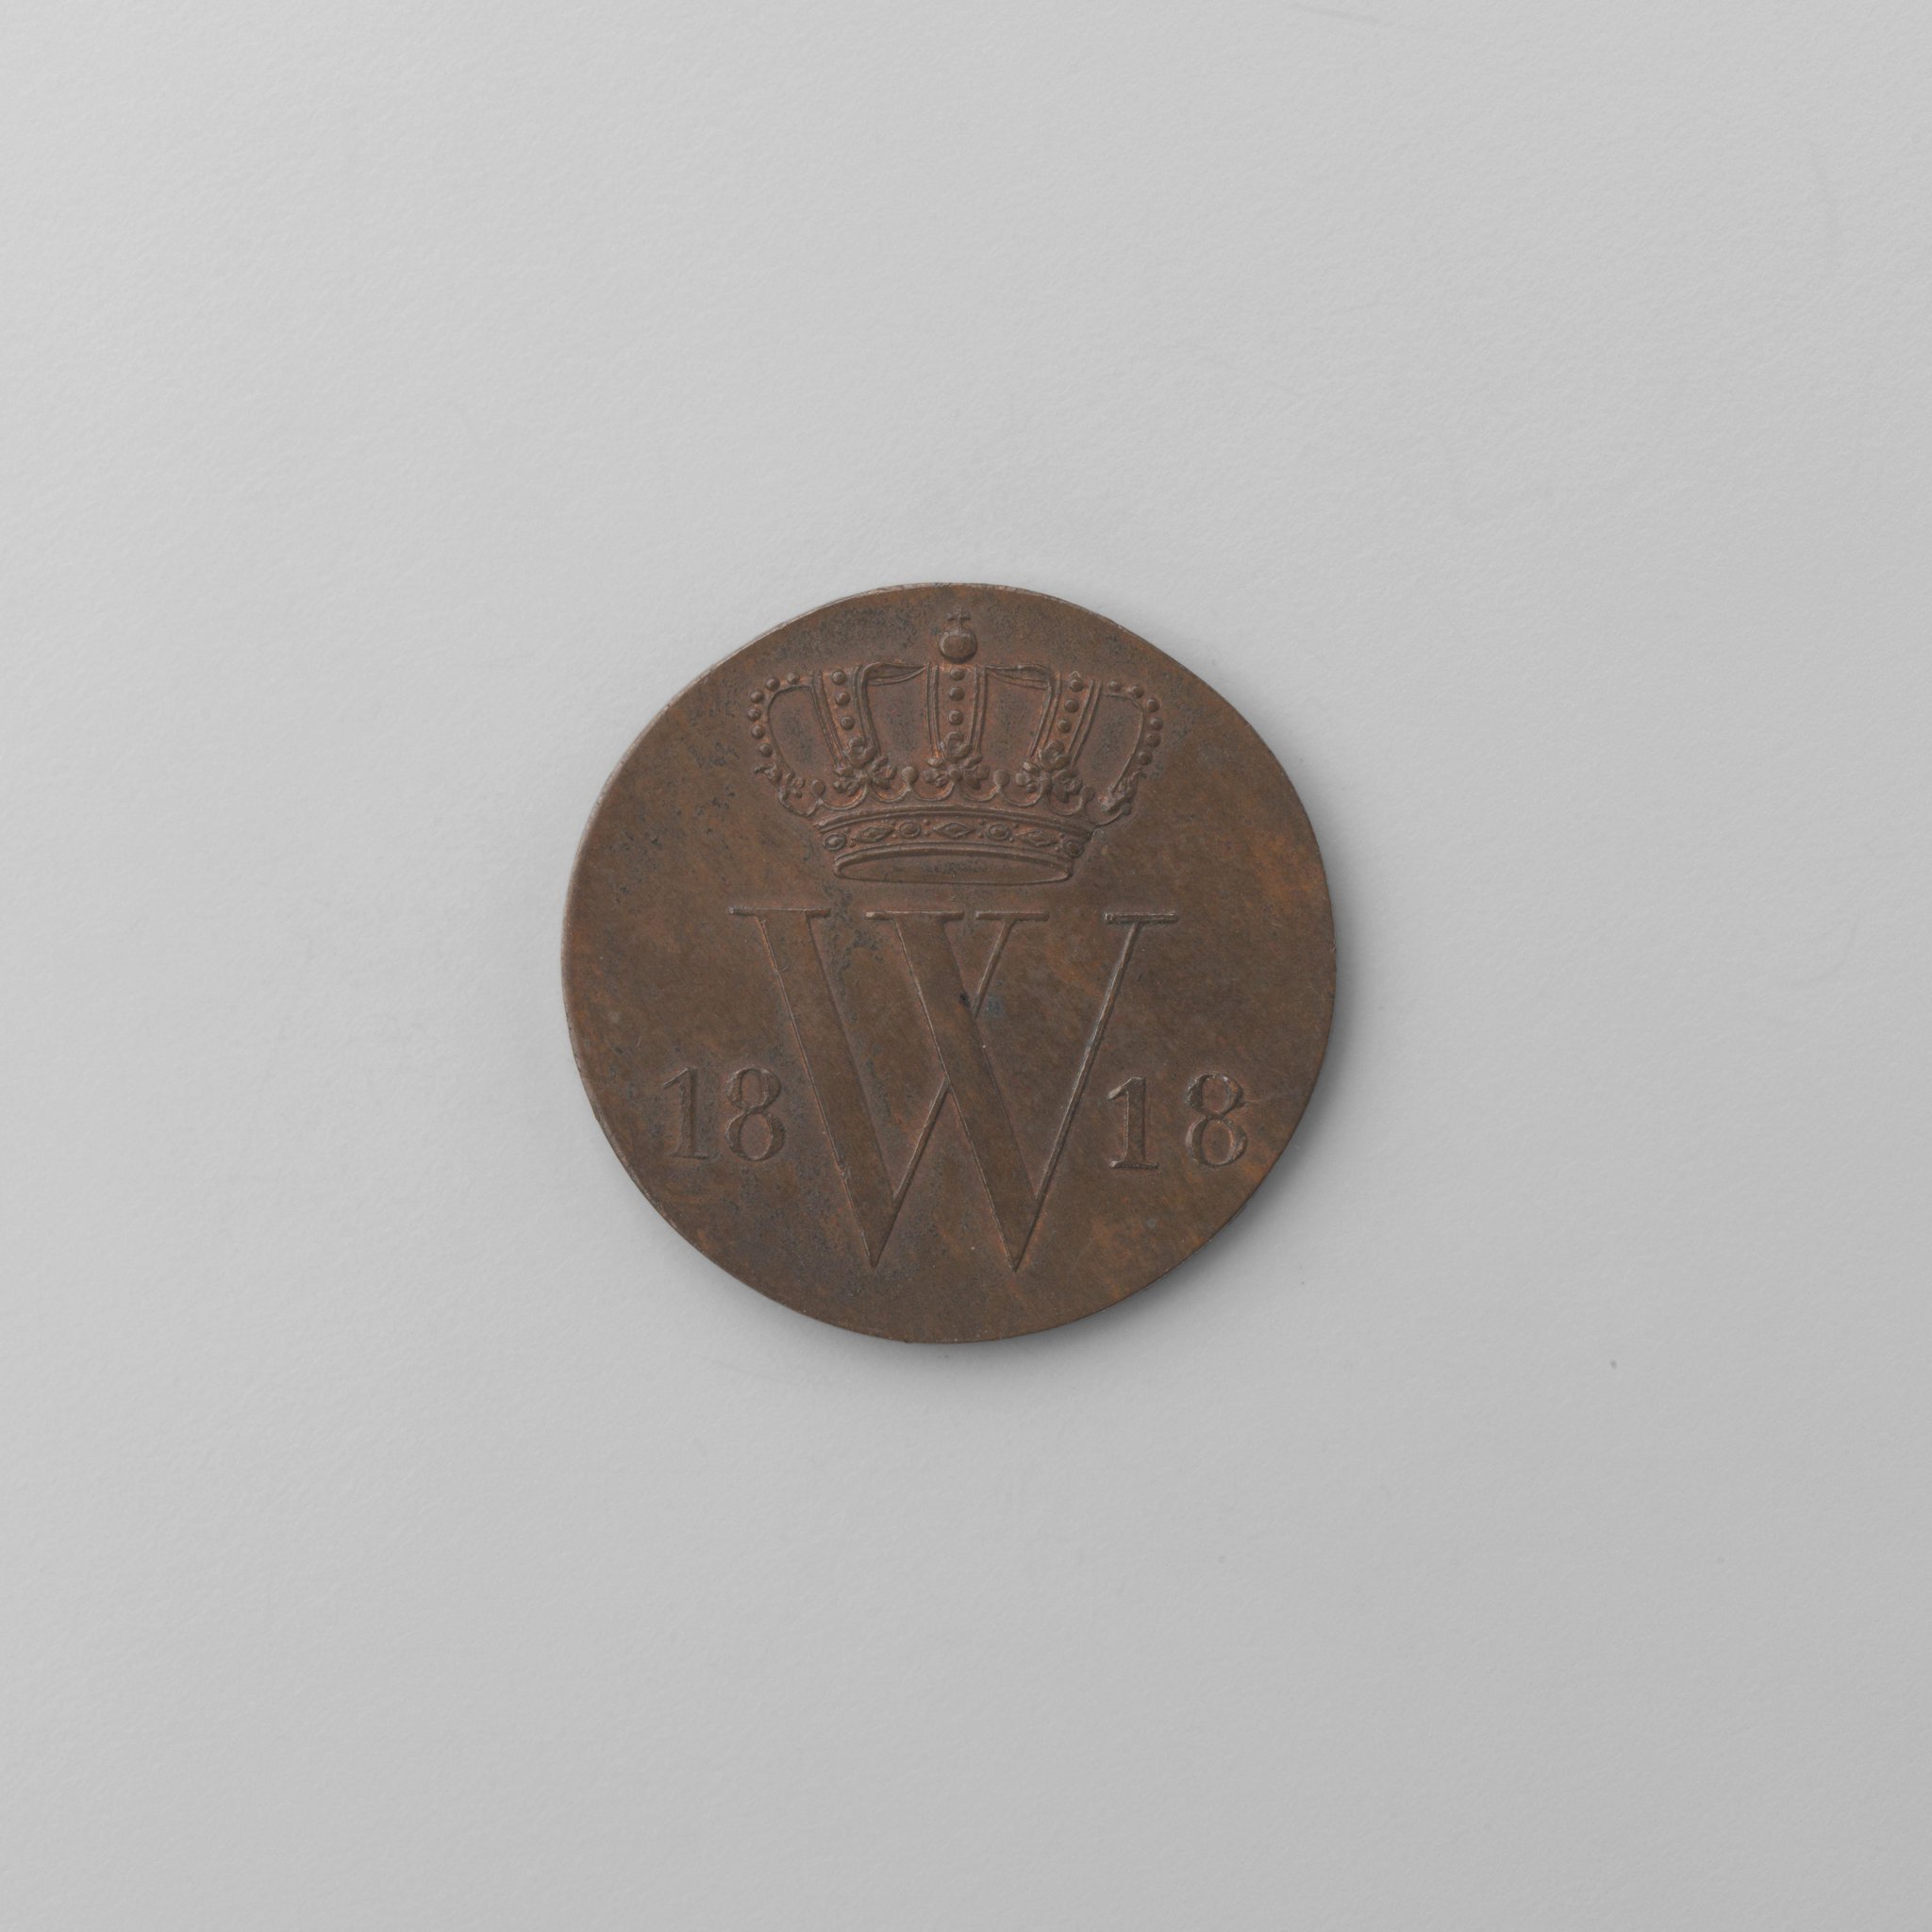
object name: coin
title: Nederland, cent, 1818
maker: william i of the netherlands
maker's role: koning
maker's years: 1772-1843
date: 1818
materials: copper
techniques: striking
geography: utrecht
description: Koperen munt. Voorzijde: tussen jaartal gekroonde rechte letter W. Keerzijde: tussen waarde-aanduiding 1 C. gekroond rijkswapenschild. Gladde rand.